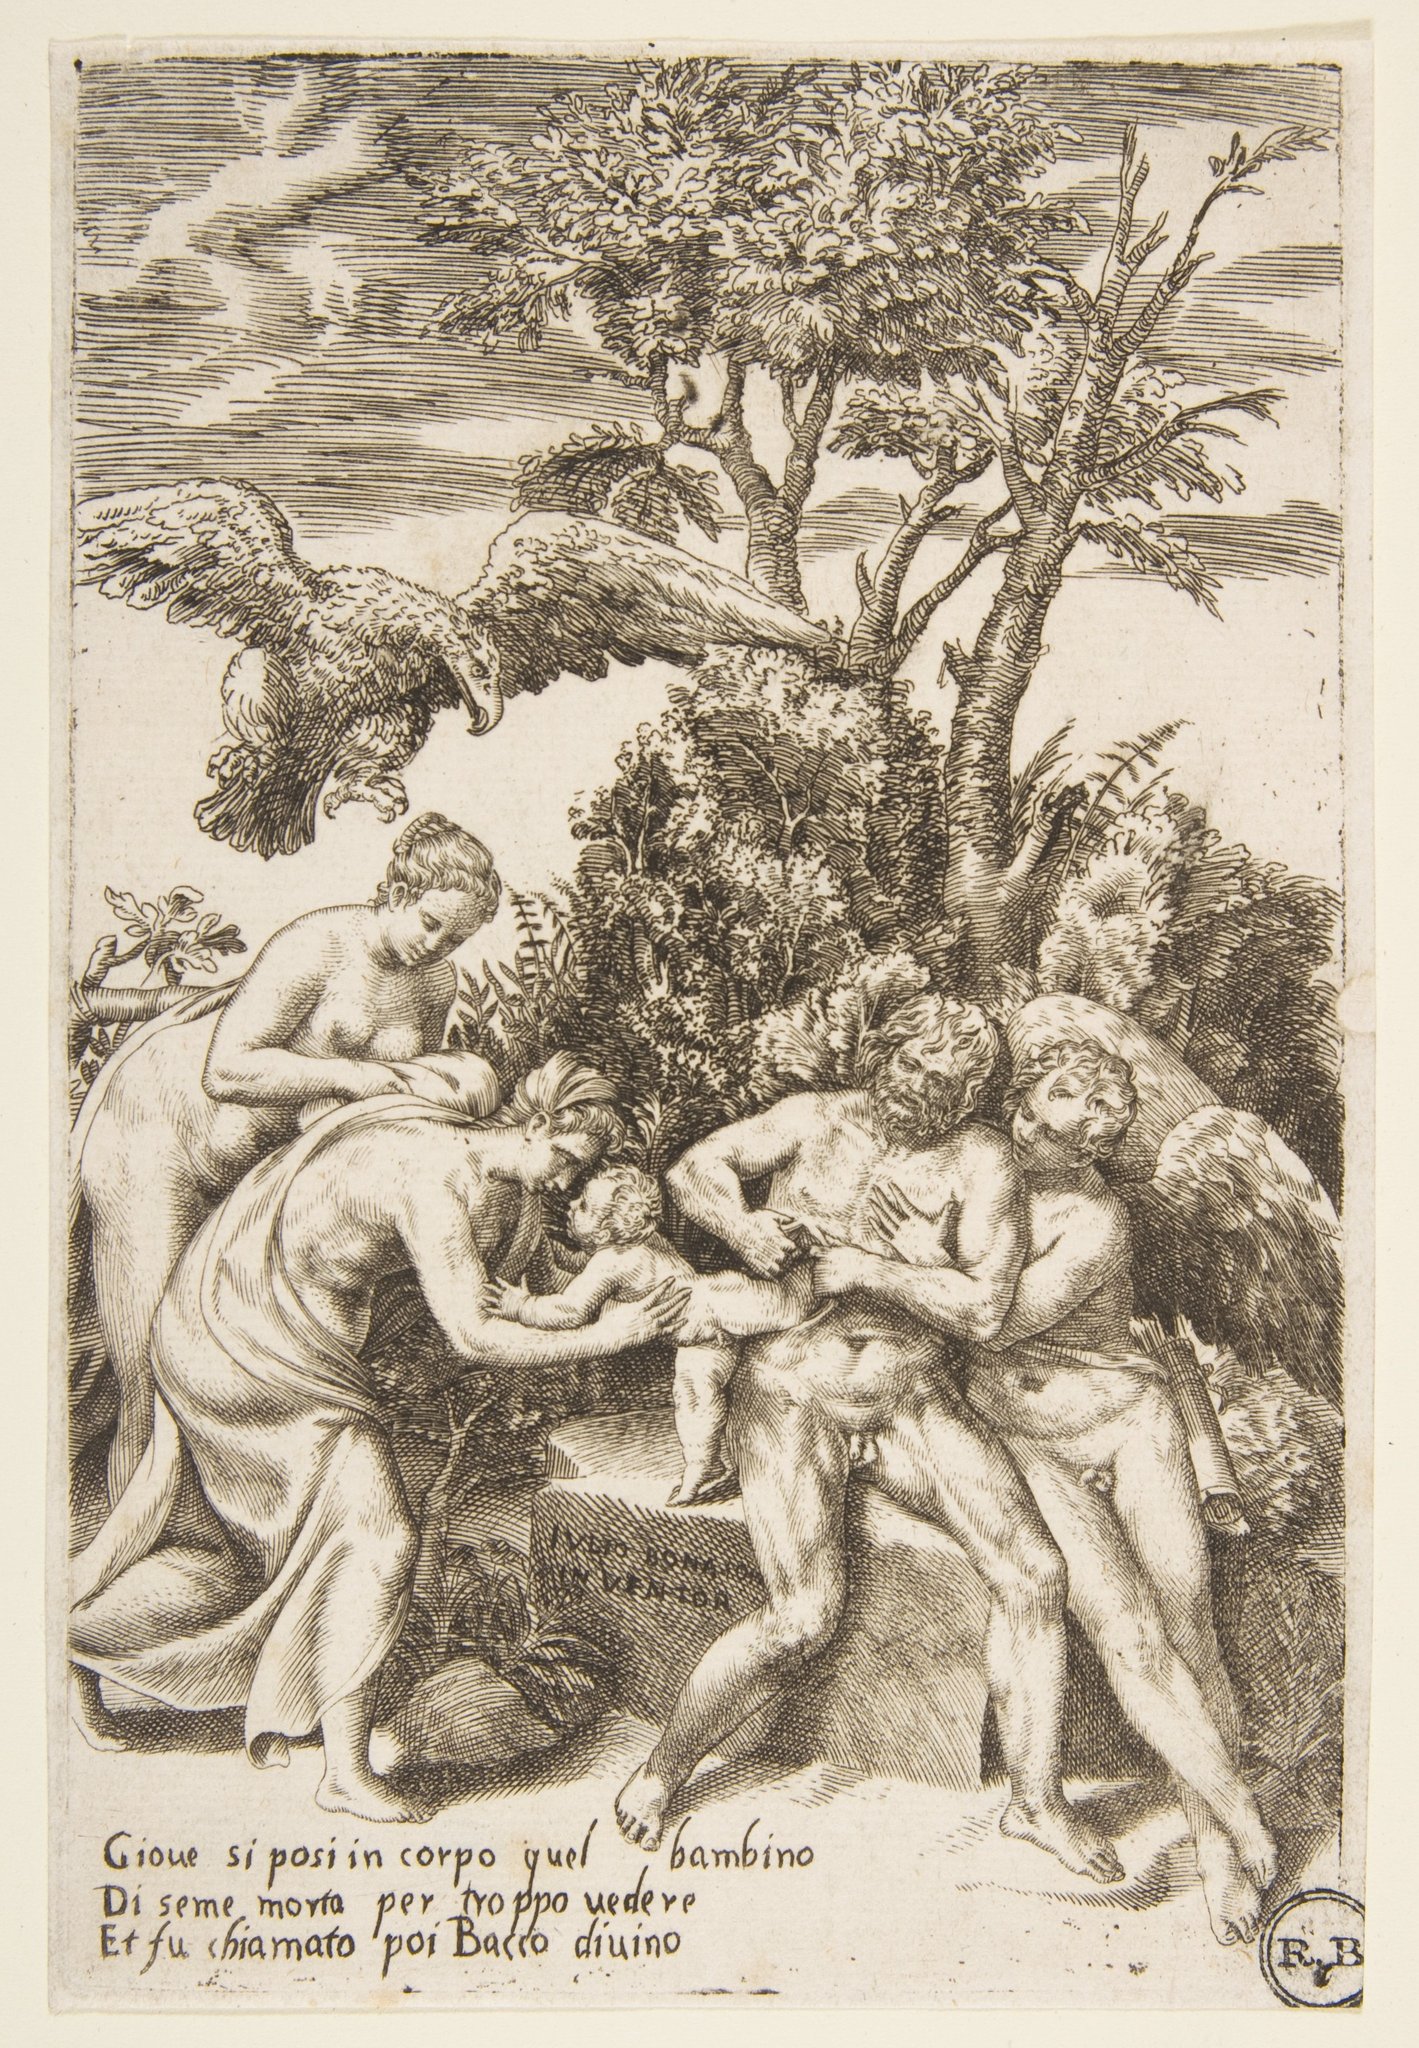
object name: print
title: The Birth of Bacchus, from "The Loves of the Gods"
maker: giulio bonasone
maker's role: artist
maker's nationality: italian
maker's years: 1510-1576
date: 1531-1576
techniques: engraving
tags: eagles,male nudes,women,female nudes,bacchus,birth